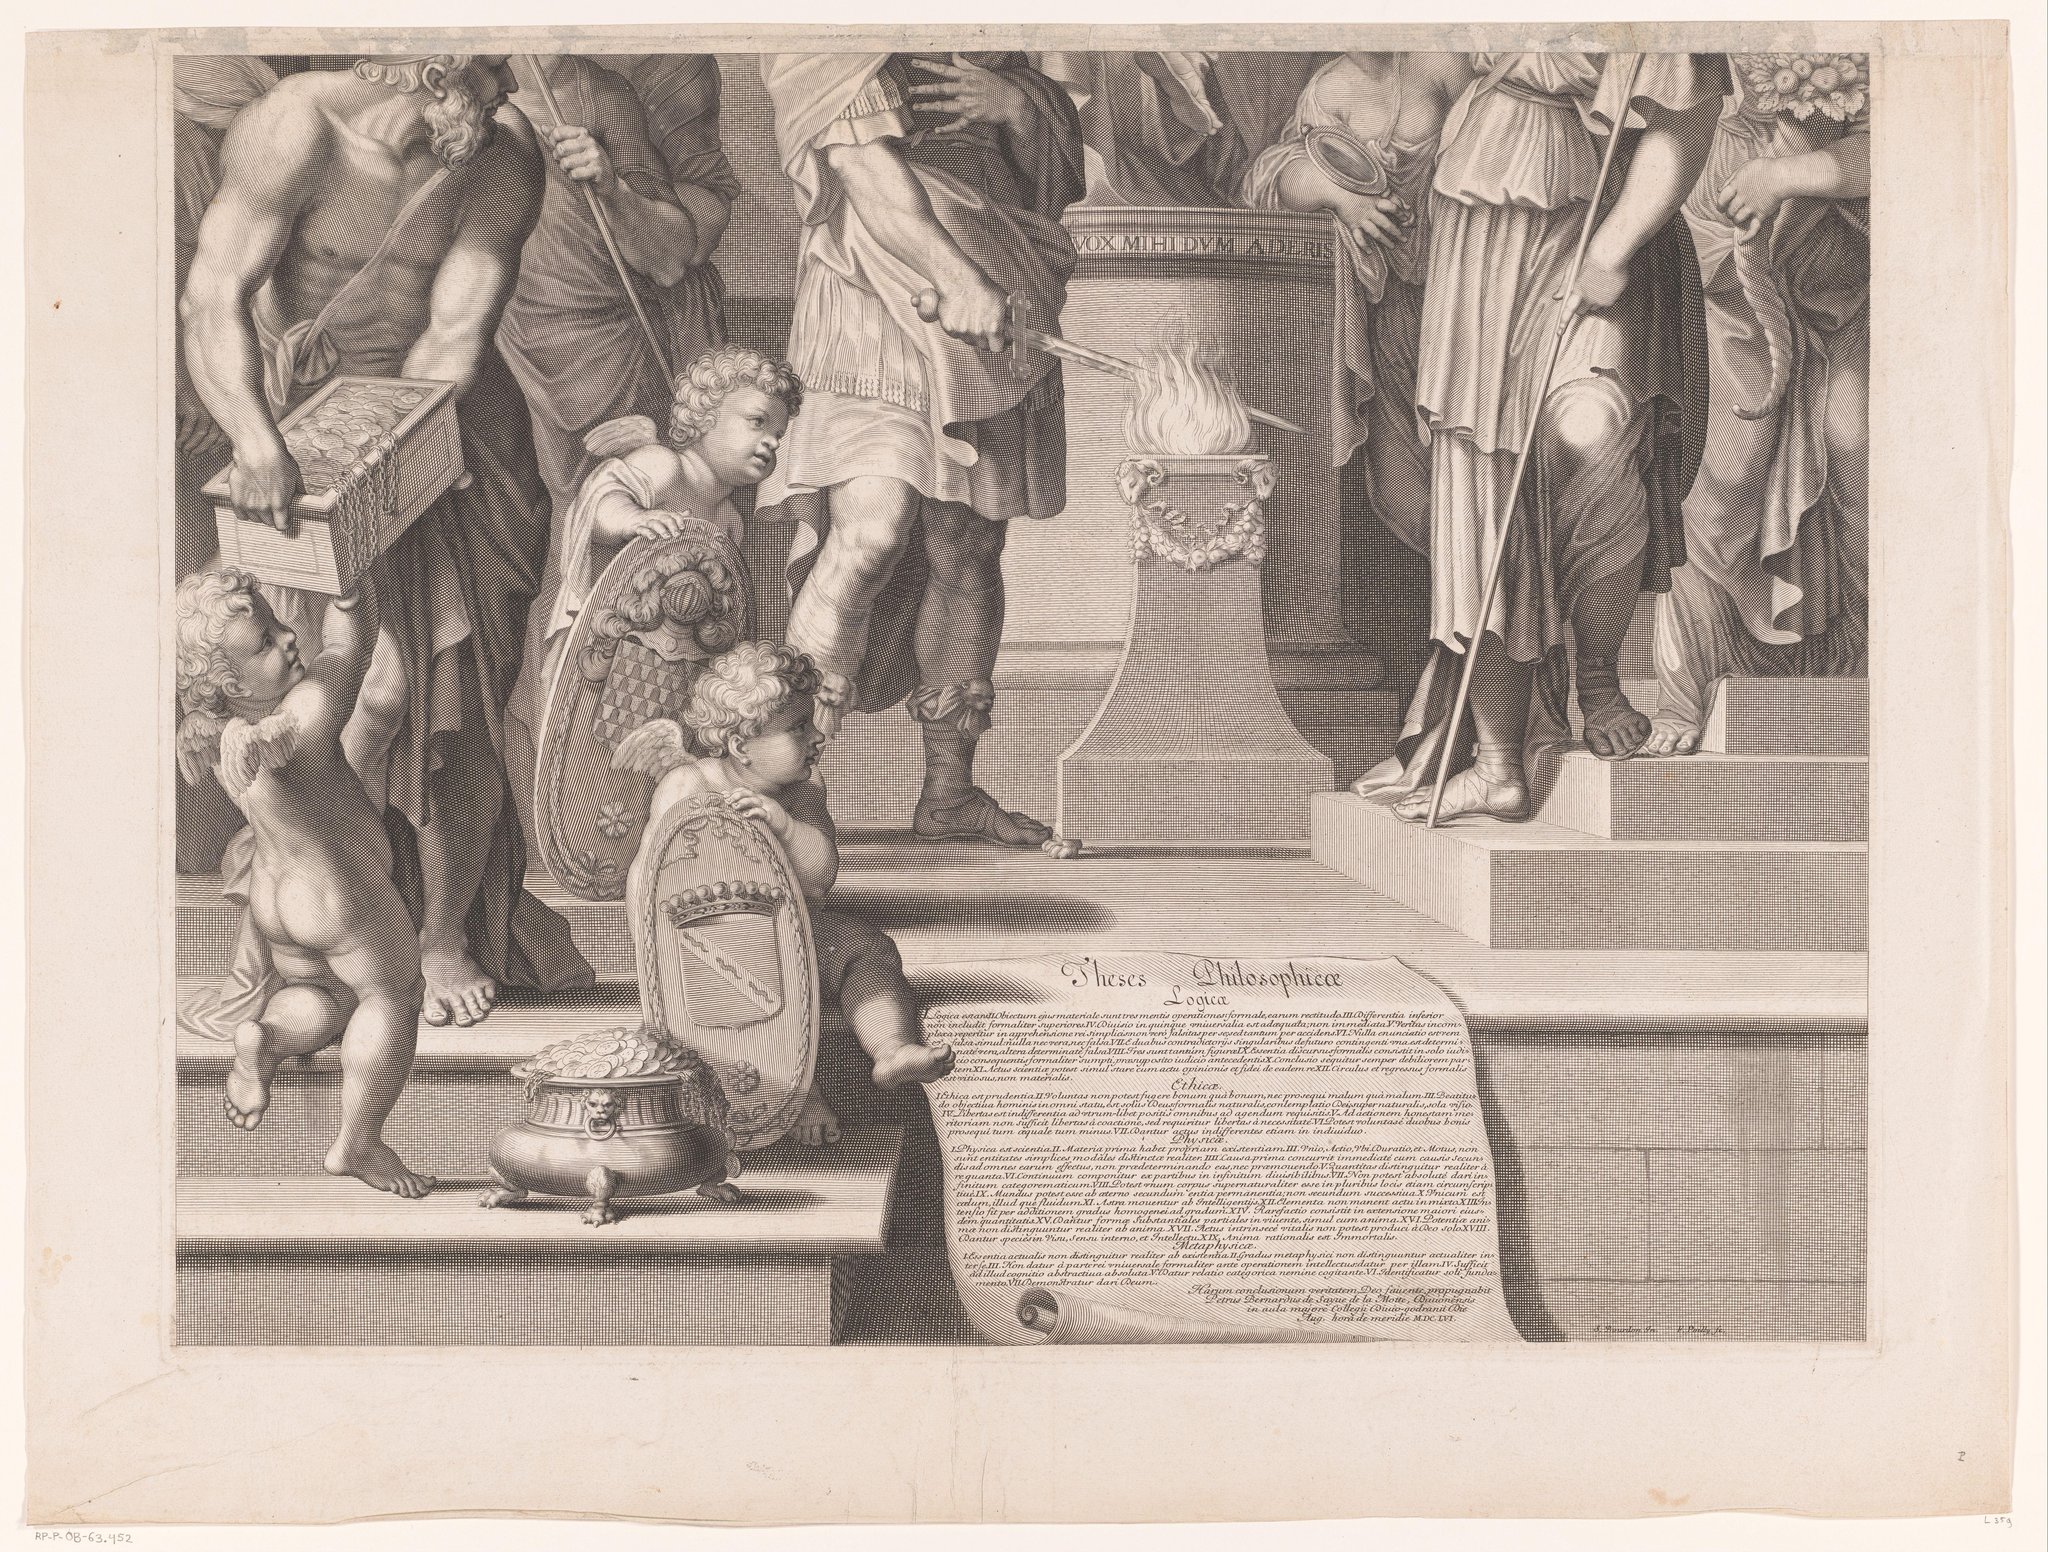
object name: print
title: Mars steekt zijn zwaard in de vlammen voor een tempel (onderste deel)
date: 1656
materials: paper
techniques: engraving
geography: france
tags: (story of) mars (ares), (story of) minerva (pallas, athena), plutus (god of wealth), son of ceres and iasion, (story of) memnon, son of aurora, philosophy, prudentia (prudence) as roman personification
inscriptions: collector's mark: Lugt 240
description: These van Pierre Bernard de Sayve de la Motte.